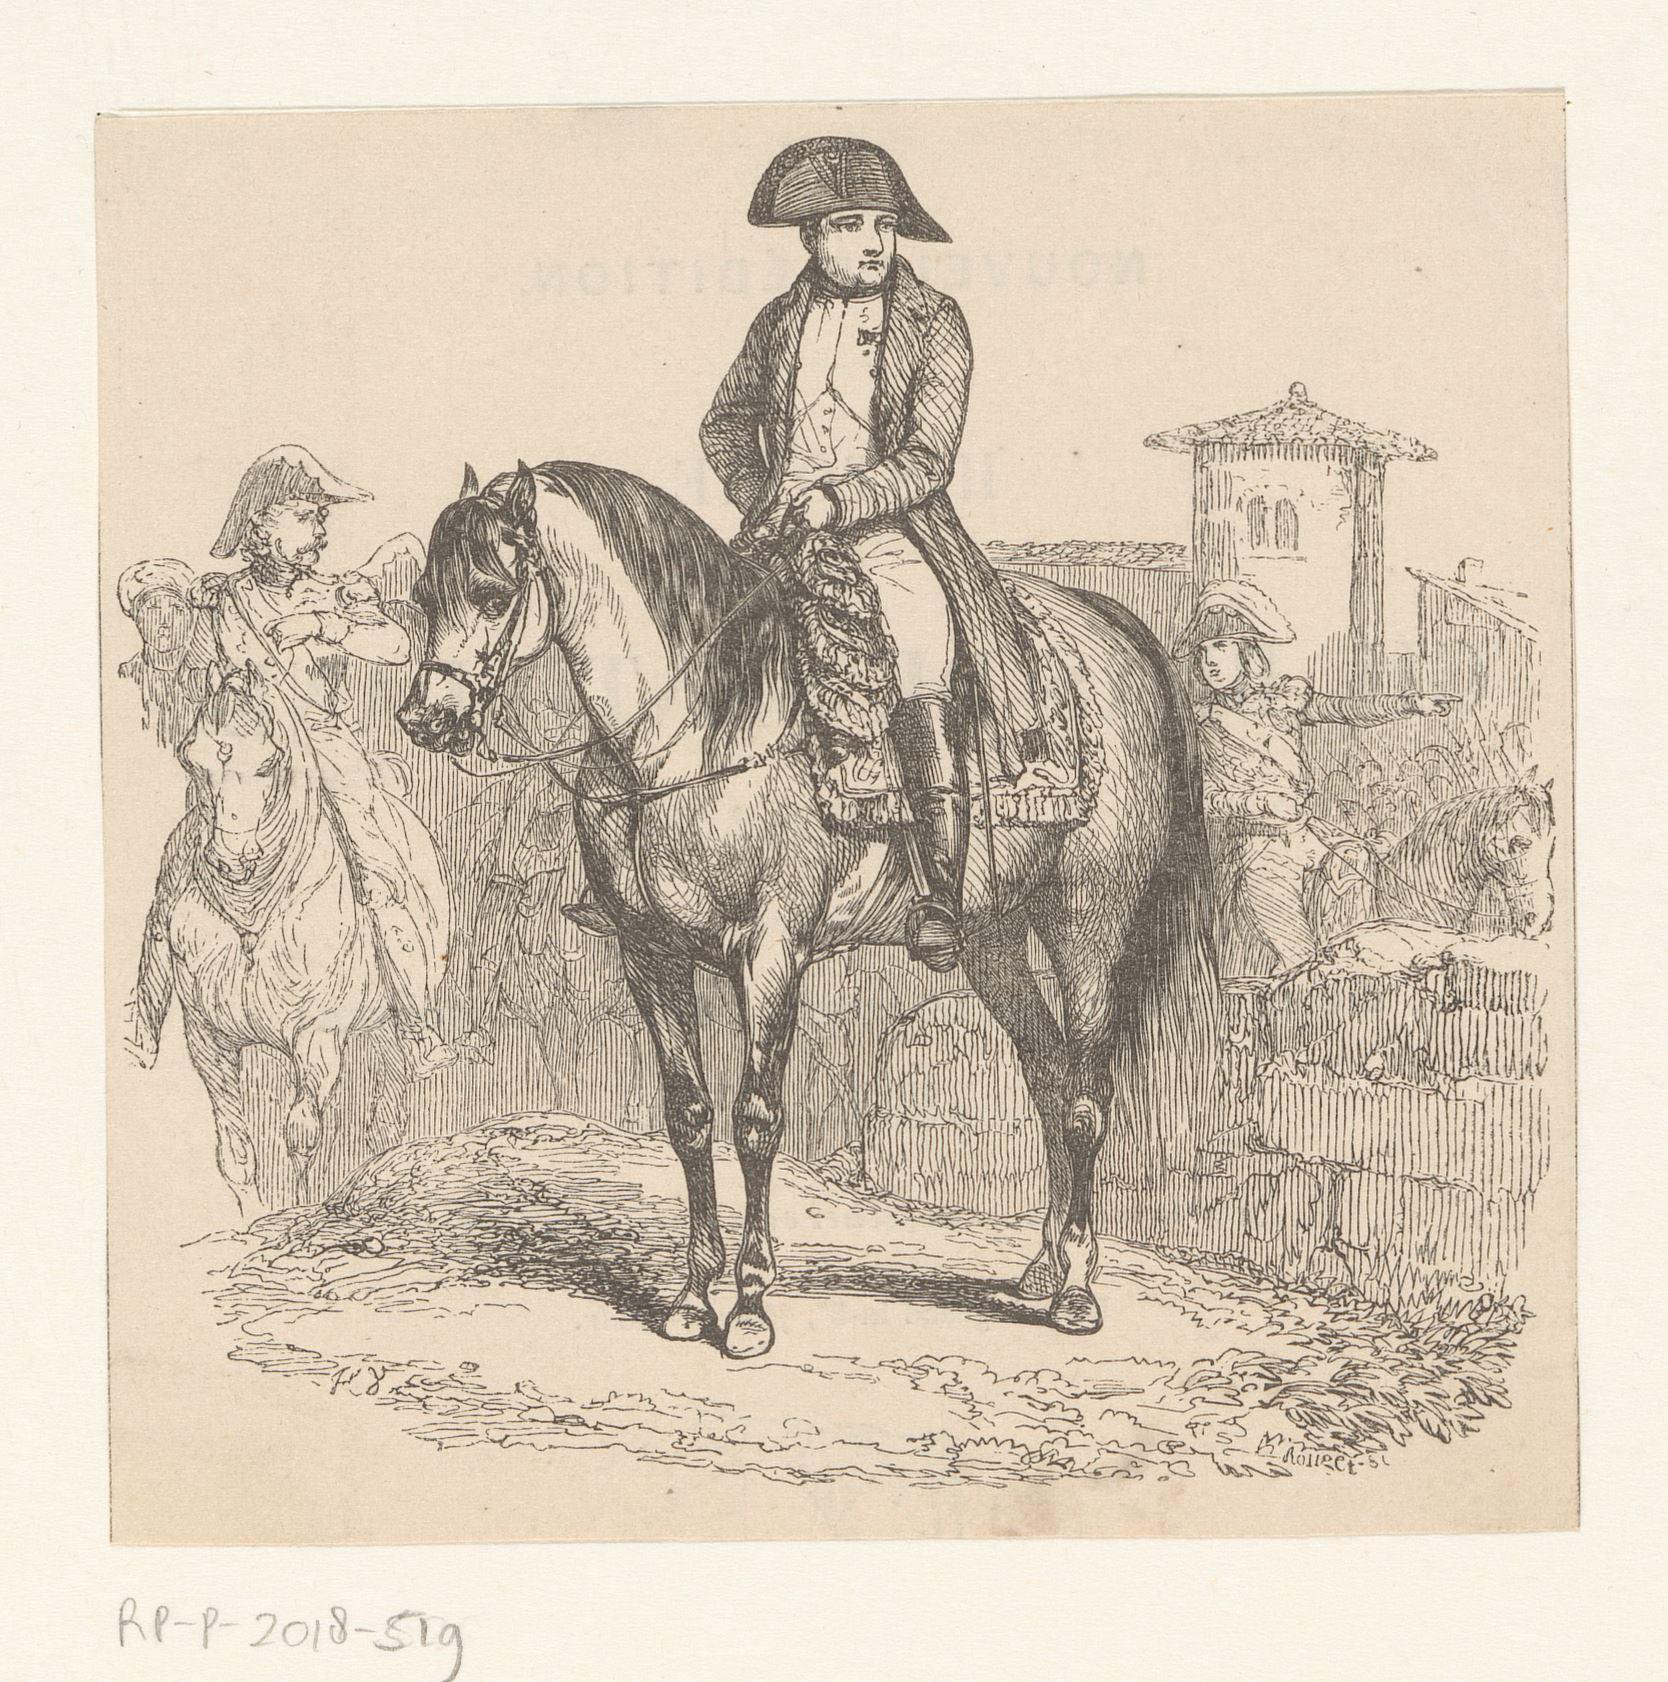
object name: print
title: Napoleon te paard, ca. 1800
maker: georges rouget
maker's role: print maker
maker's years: 1784-1869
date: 1800-1869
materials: paper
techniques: engraving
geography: france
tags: napoleon i (emperor of the french), equestrian state-portrait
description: Illustratie afkomstig uit: Histoire de Gil Blas de Santillane, par Lesage (nouvelle edition).